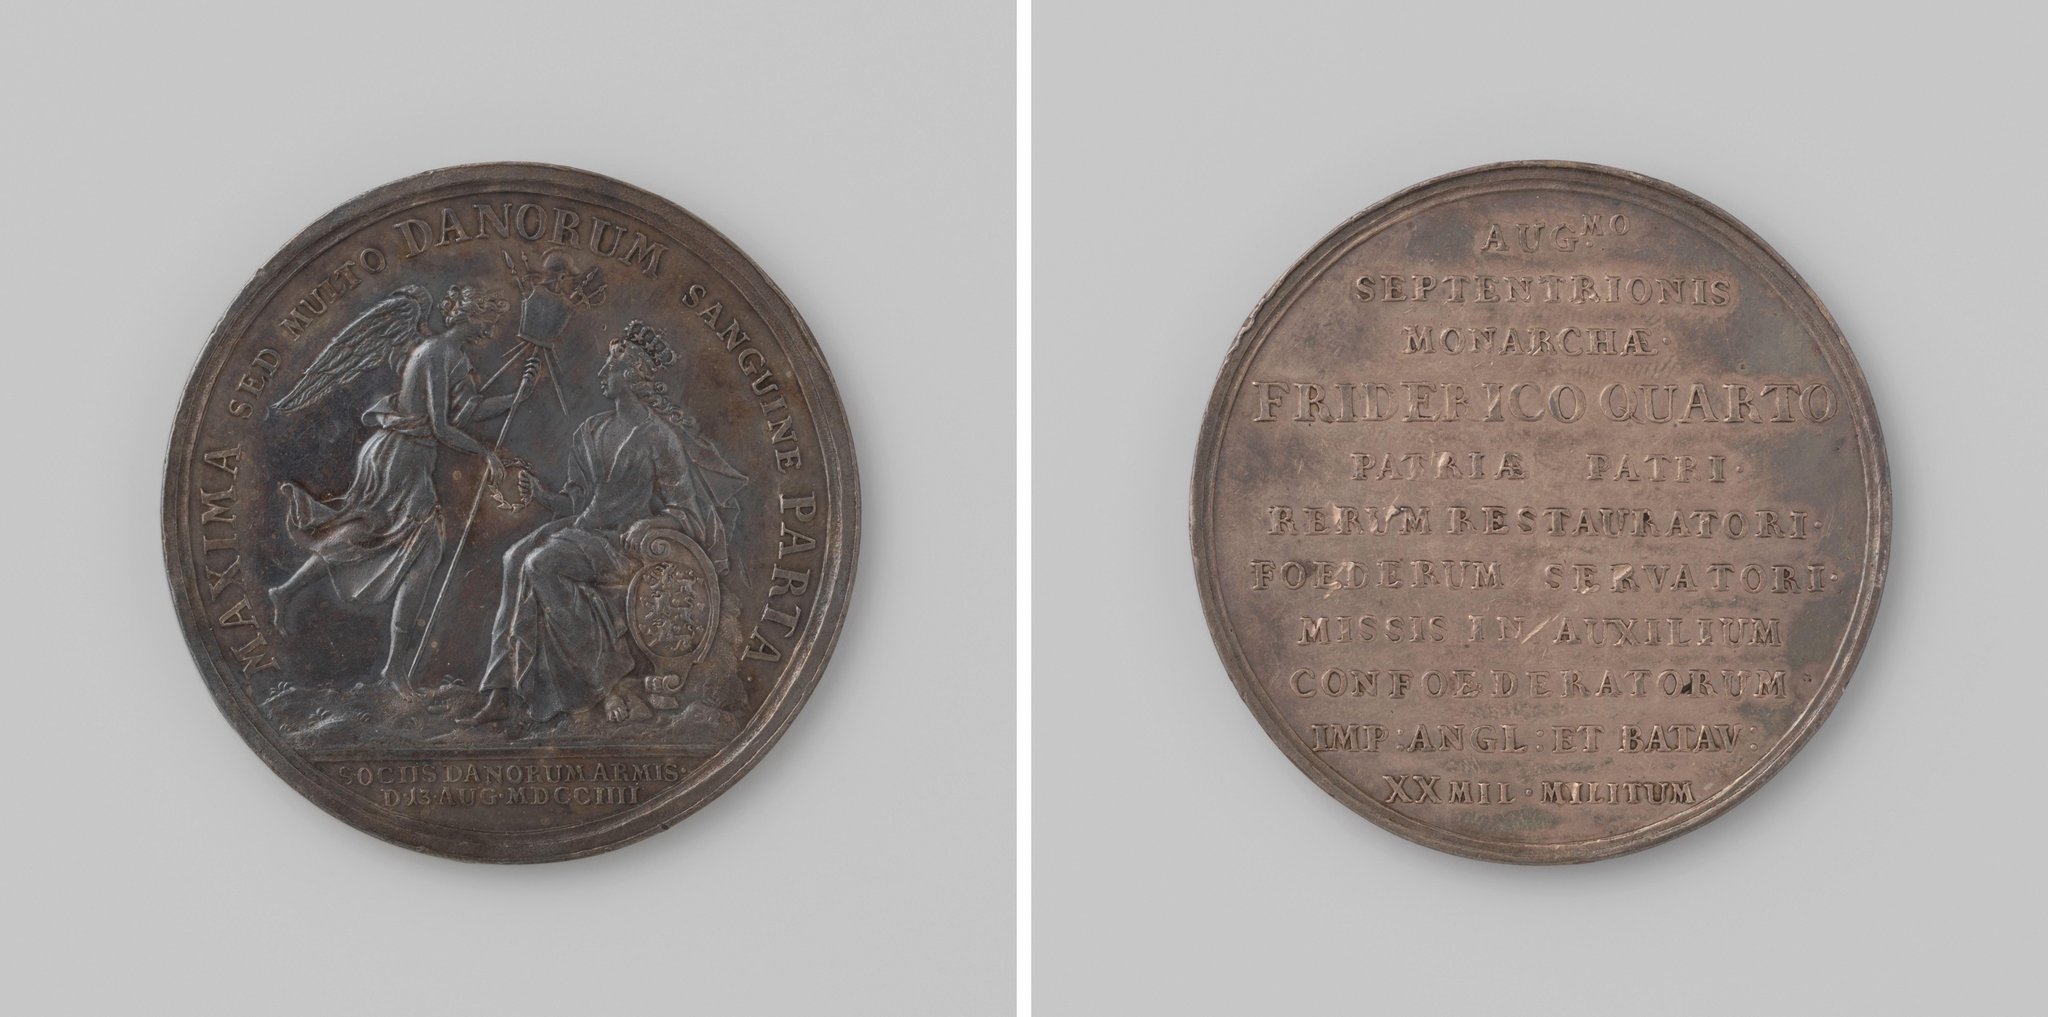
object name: history medal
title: Slag bij Blenheim, ter ere van de hulptroepen, gezonden door Frederik IV van Denemarken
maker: Anonymous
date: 1704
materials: silver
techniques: striking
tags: frederik iv (koning van denemarken en noorwegen)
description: Zilveren penning. Voorzijde: gevleugelde Overwinning schenkt Denemarken, afgebeeld als zittende vrouw met kroon en wapenschild lauwerkrans en trophee binnen omschrift; afsnede: opschrift. Keerzijde: opschrift